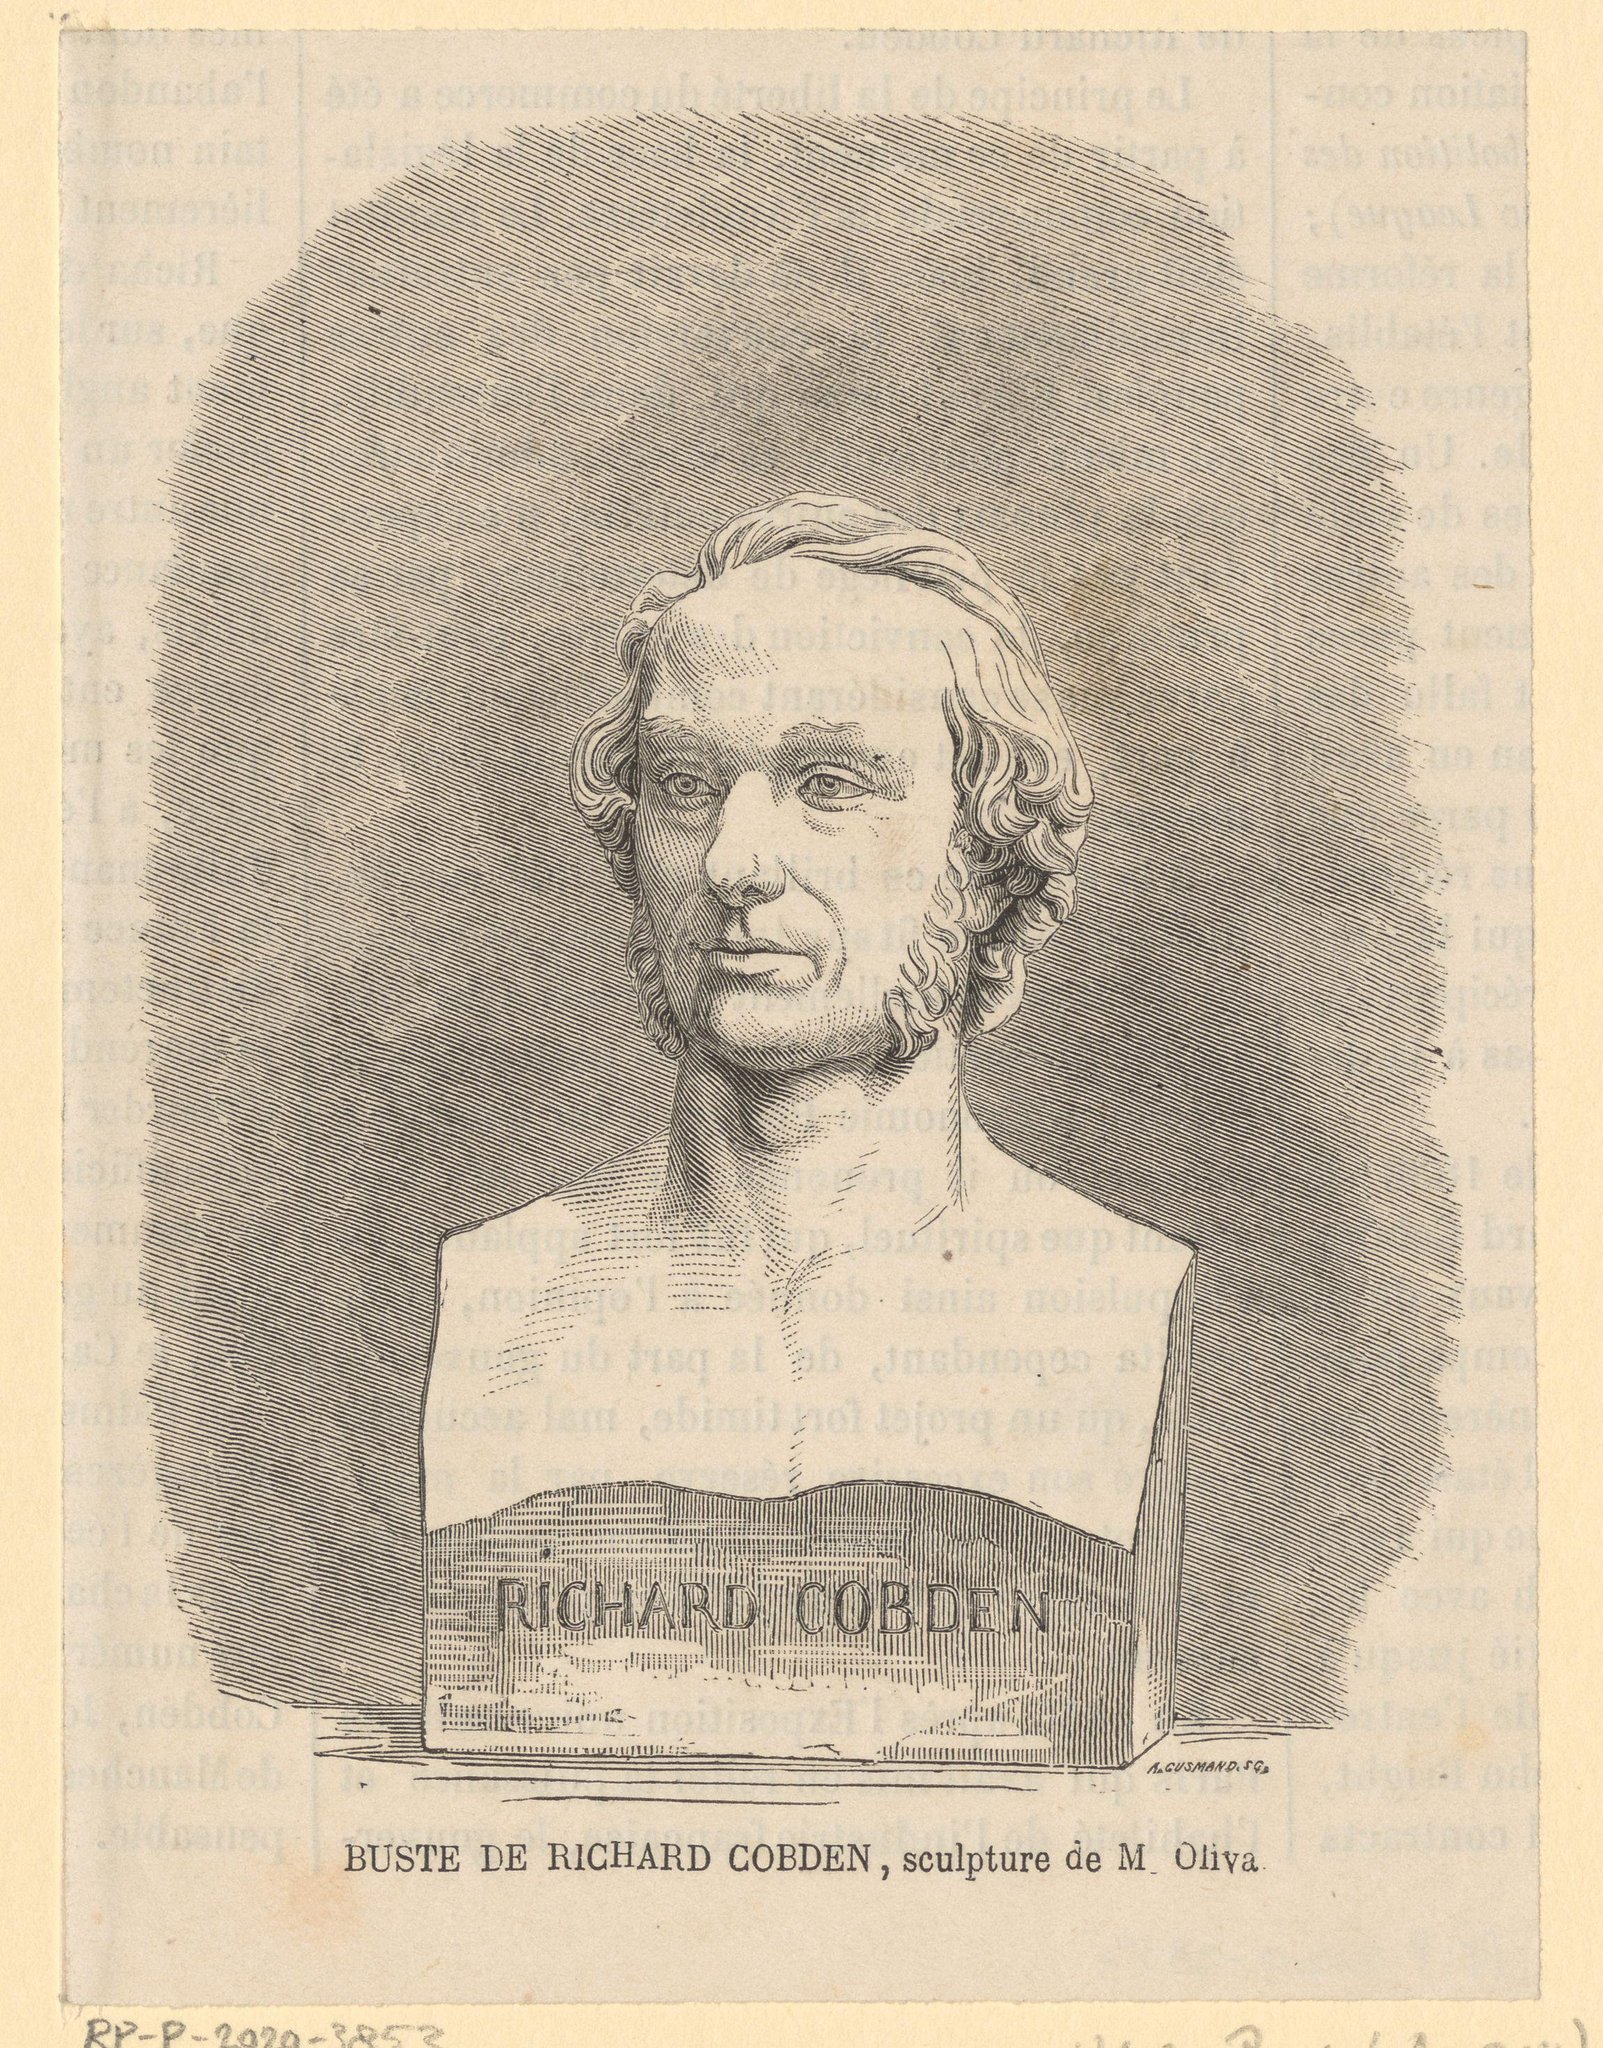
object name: print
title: Portretbuste van Richard Cobden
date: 1867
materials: paper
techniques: letterpress printing, engraving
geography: paris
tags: manufacturer, historical persons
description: Prent uit: L'Exposition universelle, nr. 56, 14 november 1867.